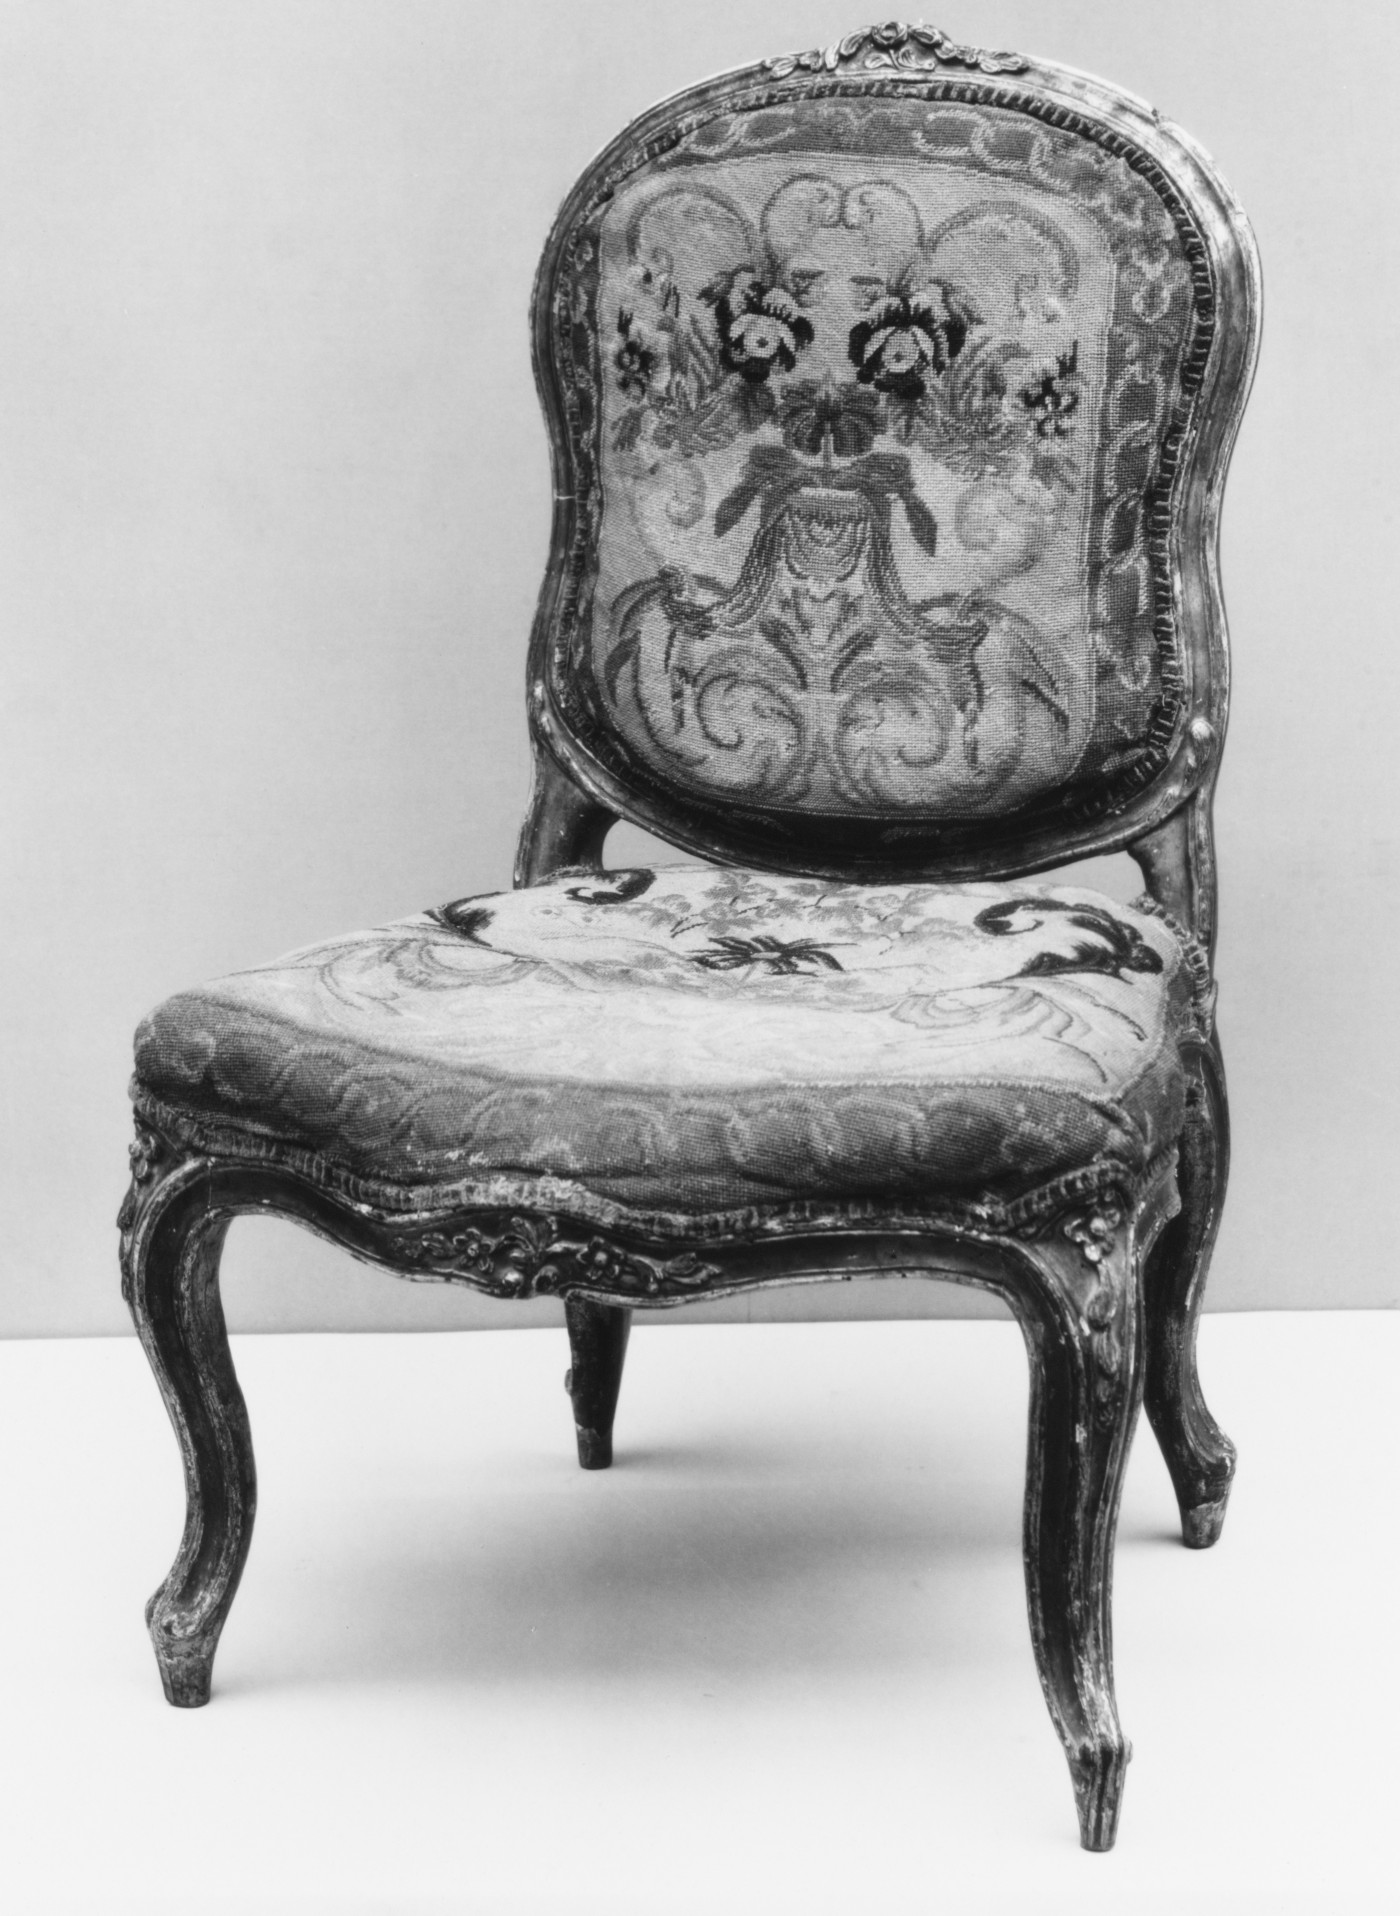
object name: side chair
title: Side chairs (one of a pair; part of a set)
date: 1734-1766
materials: wood, wool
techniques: embroidery, painting, silvered